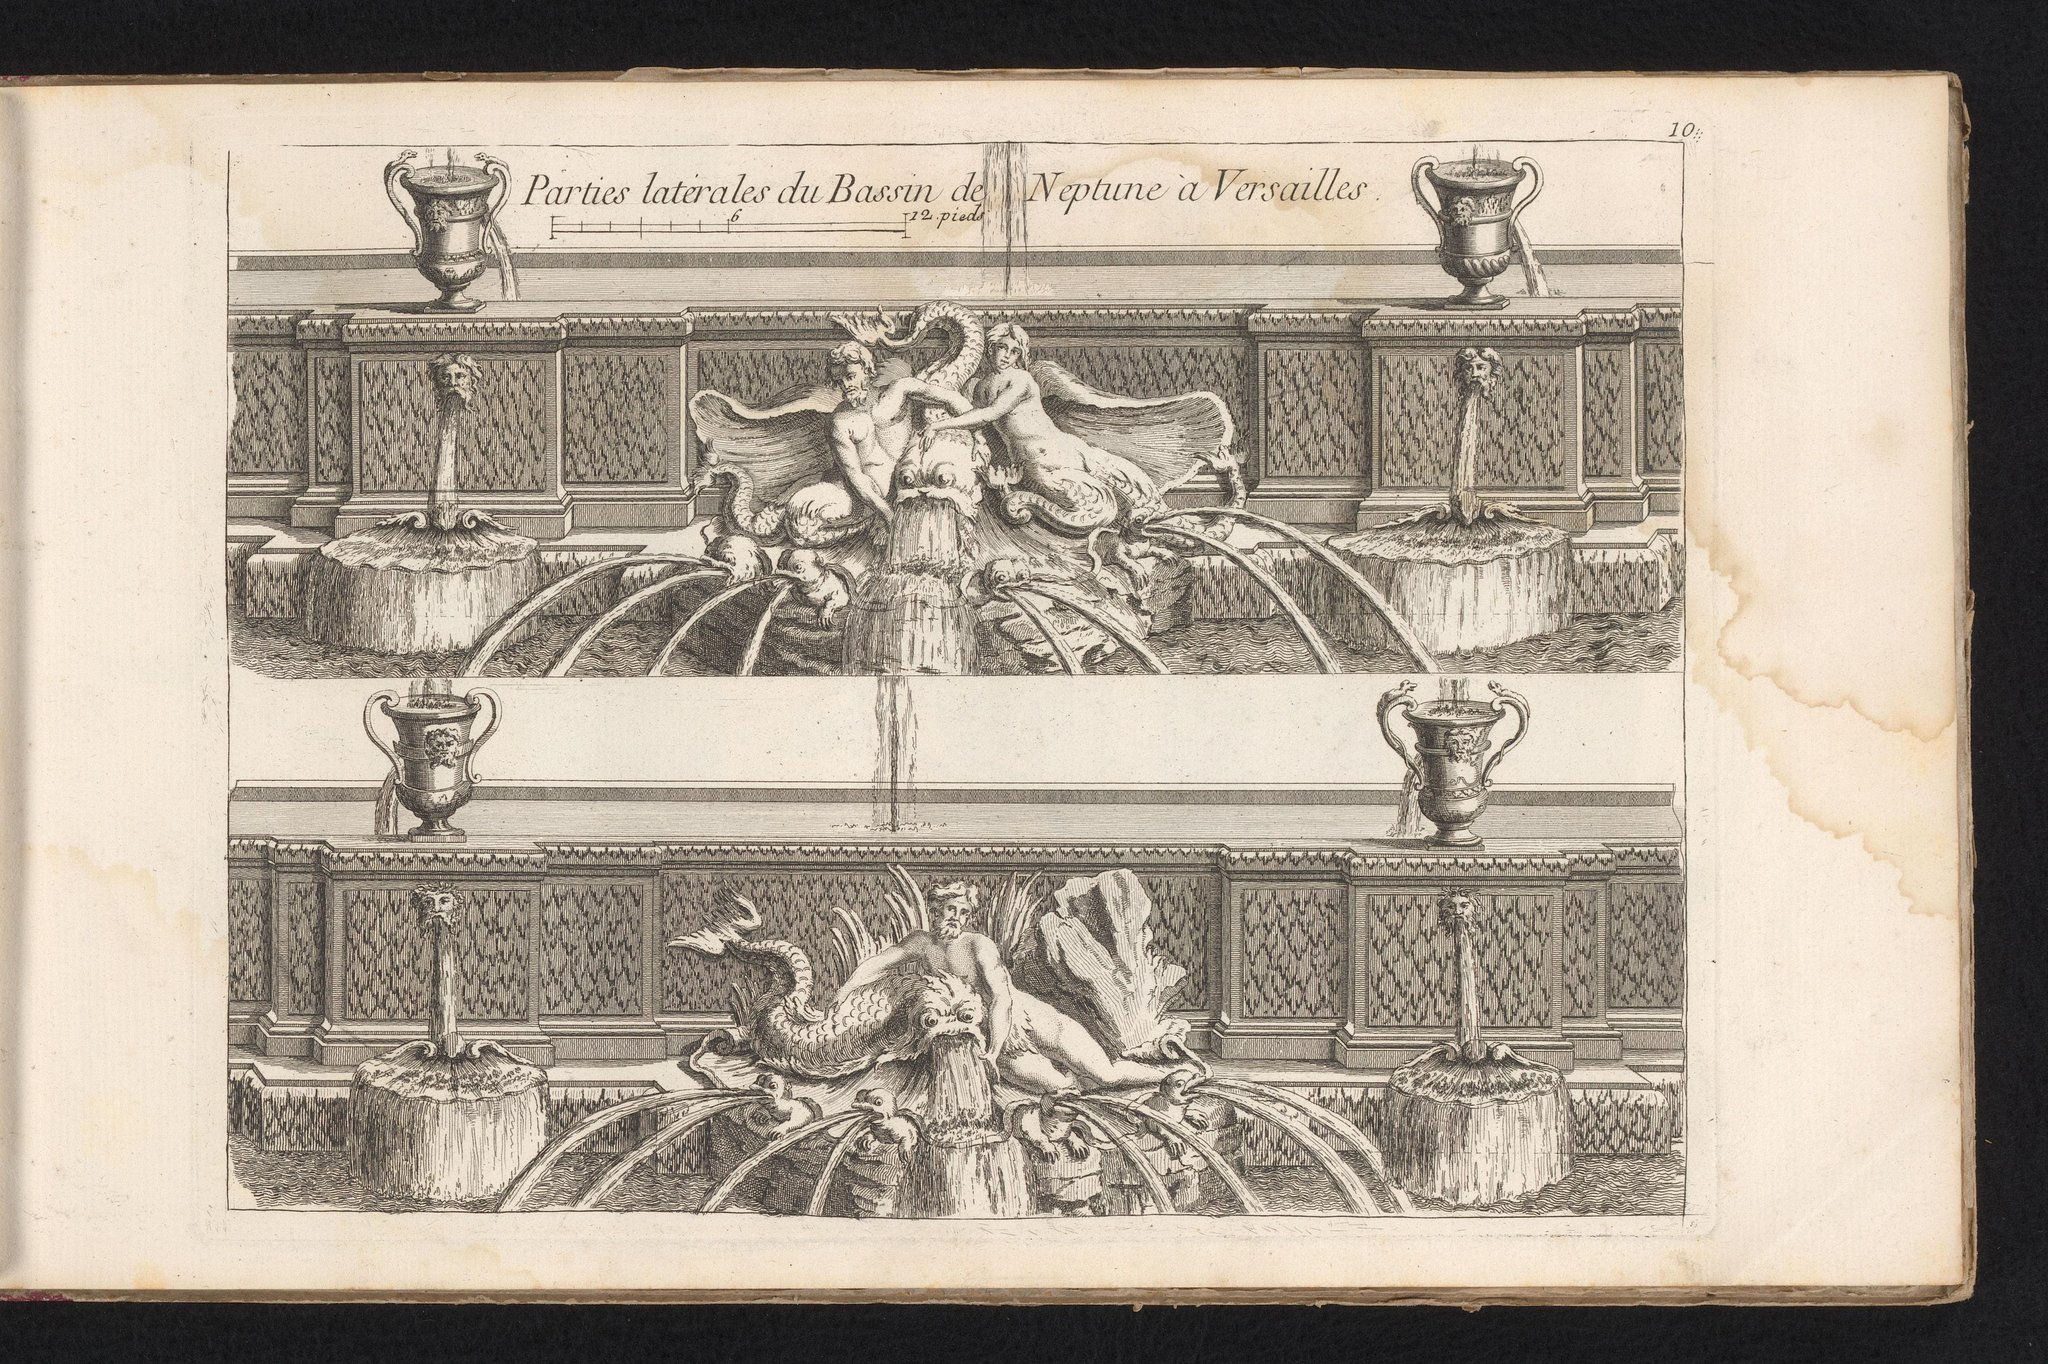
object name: album leaf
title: Landschapstuinen in Chinees-Engelse stijl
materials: paper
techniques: engraving, etching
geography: paris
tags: garden fountain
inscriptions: collector's mark: Lugt 2228, collector's mark: Lugt 2760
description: De serie 'Jardins anglo-chinois à la mode' verscheen in totaal in 21 zogeheten 'cahiers' (afleveringen). De huidige prent komt uit het zesde 'cahier'. Het Rijksmuseum Amsterdam bezit drie banden met daarin in totaal zes 'cahiers' van deze reeks. In de documentatie wordt verwezen naar een in de bibliotheek van het Rijksmuseum Amsterdam aanwezige facsimile van het complete werk.